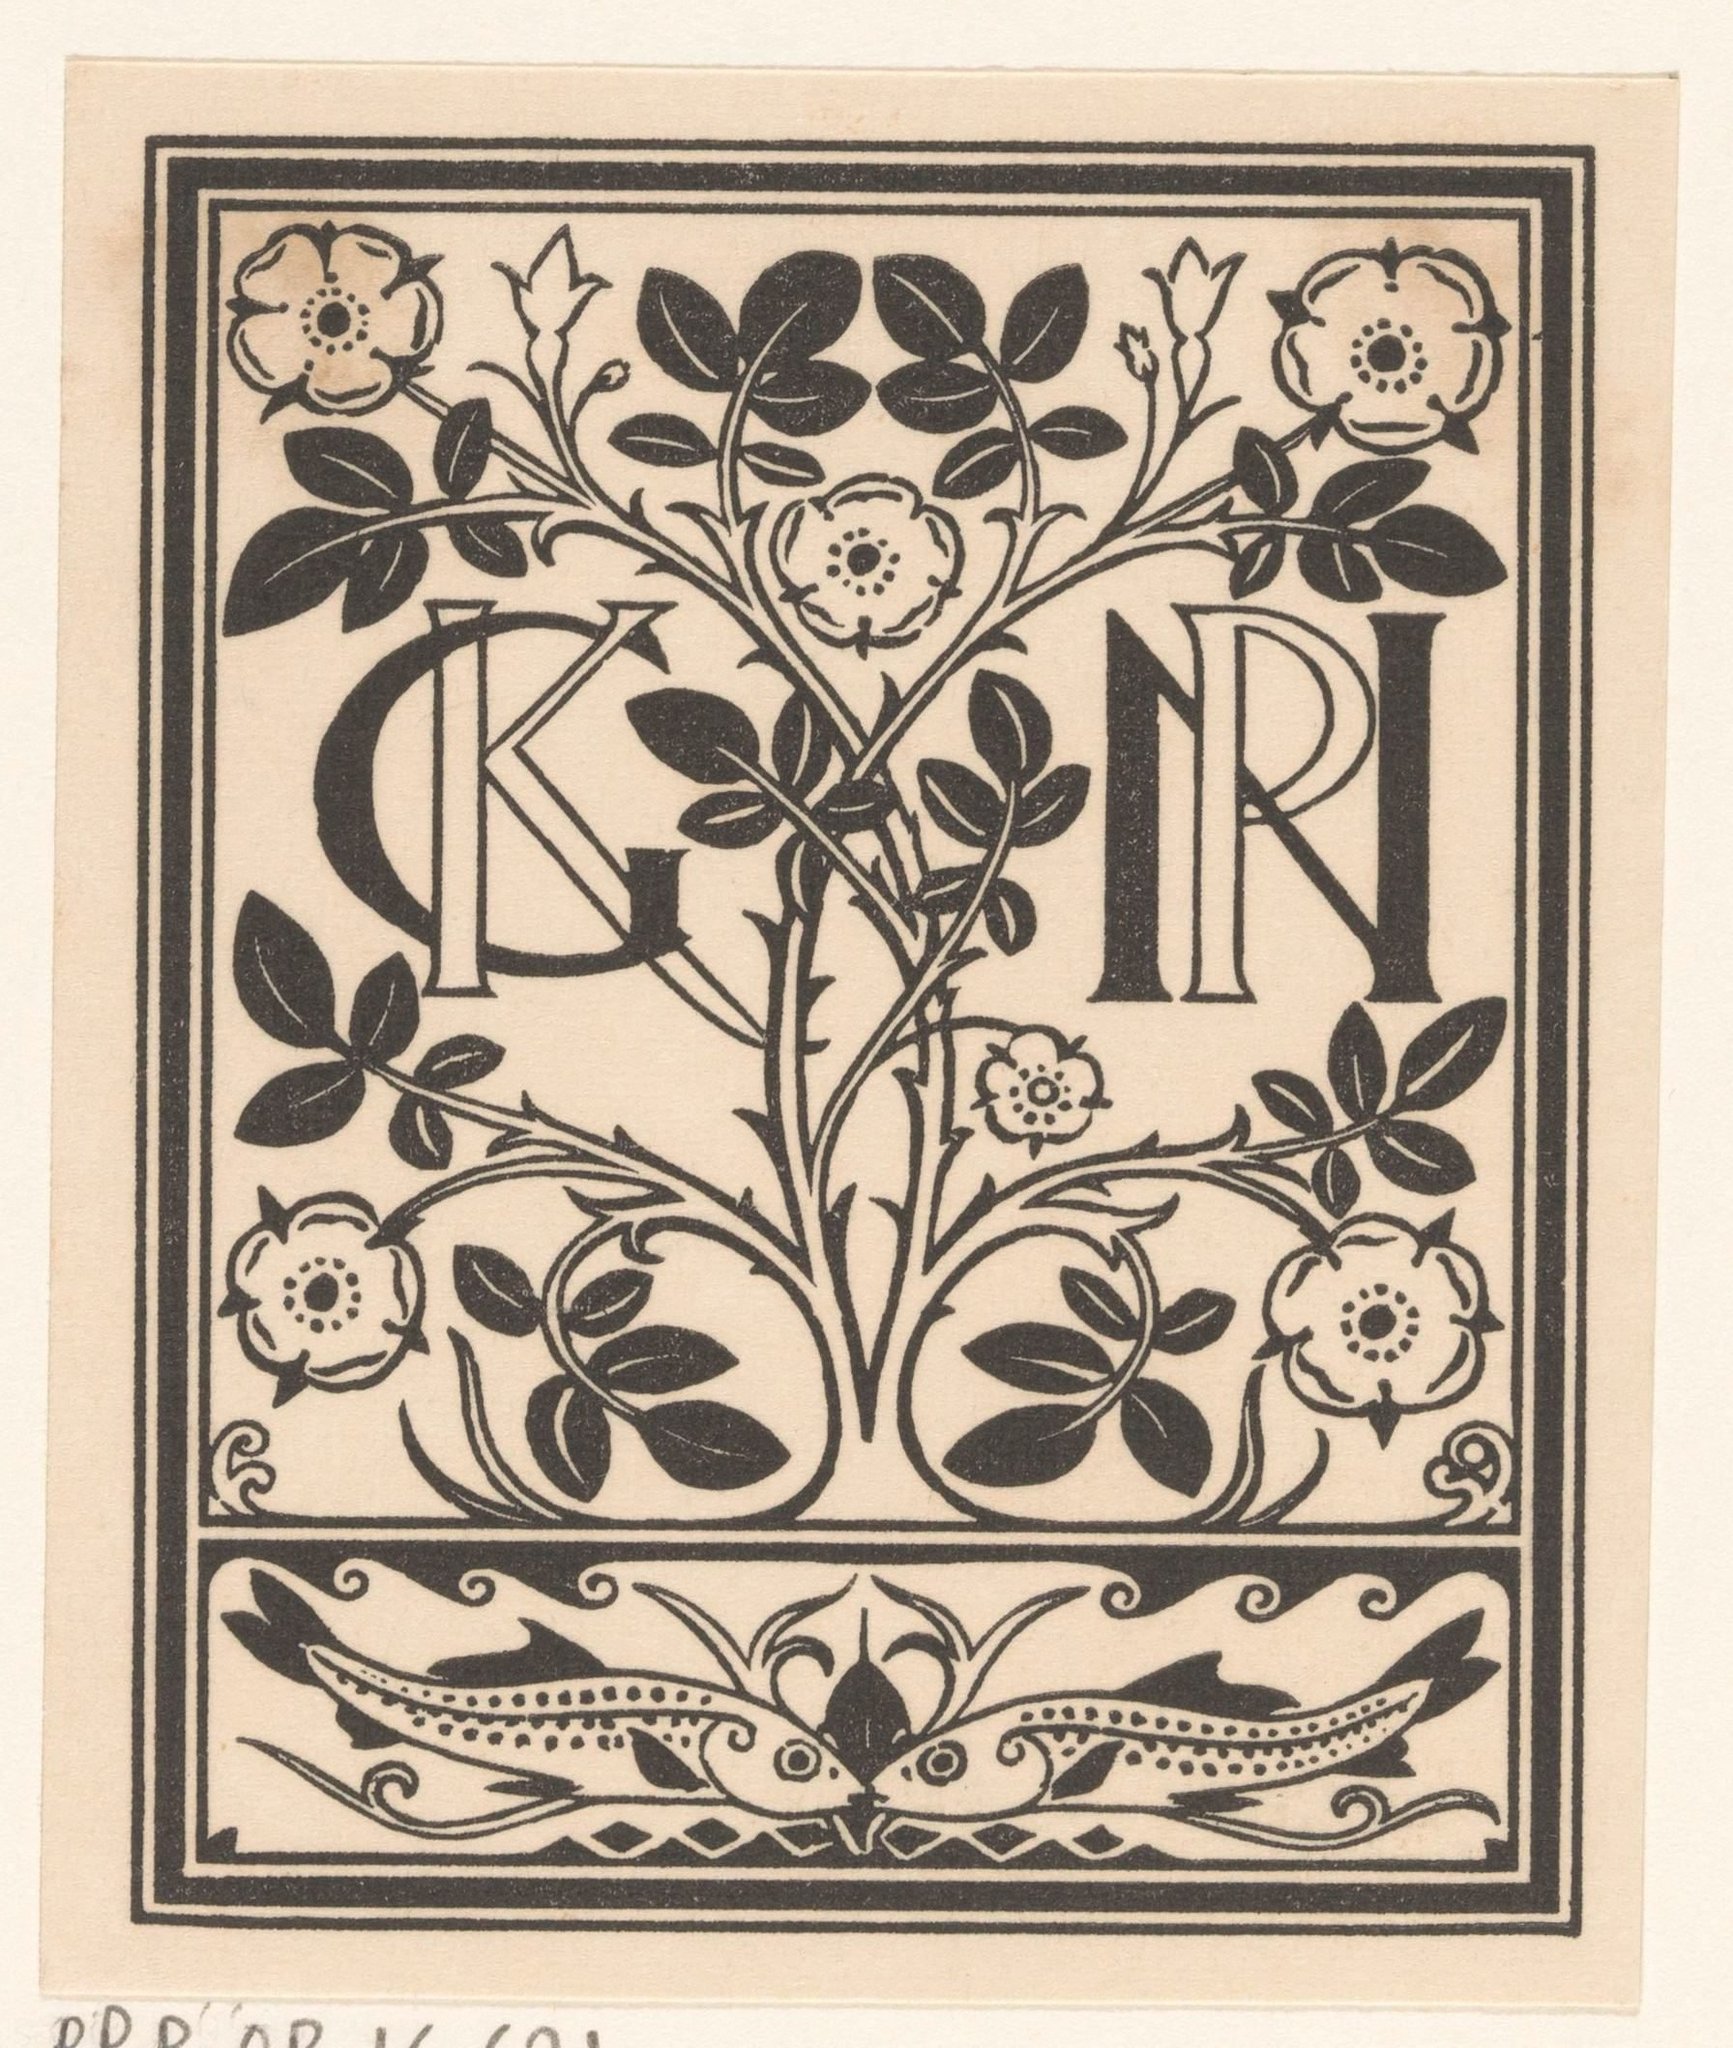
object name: print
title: Ex libris voor Klaas Groesbeek en Paul Nijhoff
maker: gerrit willem dijsselhof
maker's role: designer, draughtsman, print maker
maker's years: 1866-1924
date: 1876-1924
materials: paper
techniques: woodcut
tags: klaas groesbeek, fishes, shrubs: rose-bush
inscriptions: collector's mark: Lugt 2228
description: De initialen van Klaas Groesbeek en Paul Nijhoff, de directeuren van boekhandel Scheltema & Holkema in Amsterdam, in een rechthoek die verder is opgevuld met een rozenstruik en twee vissen.